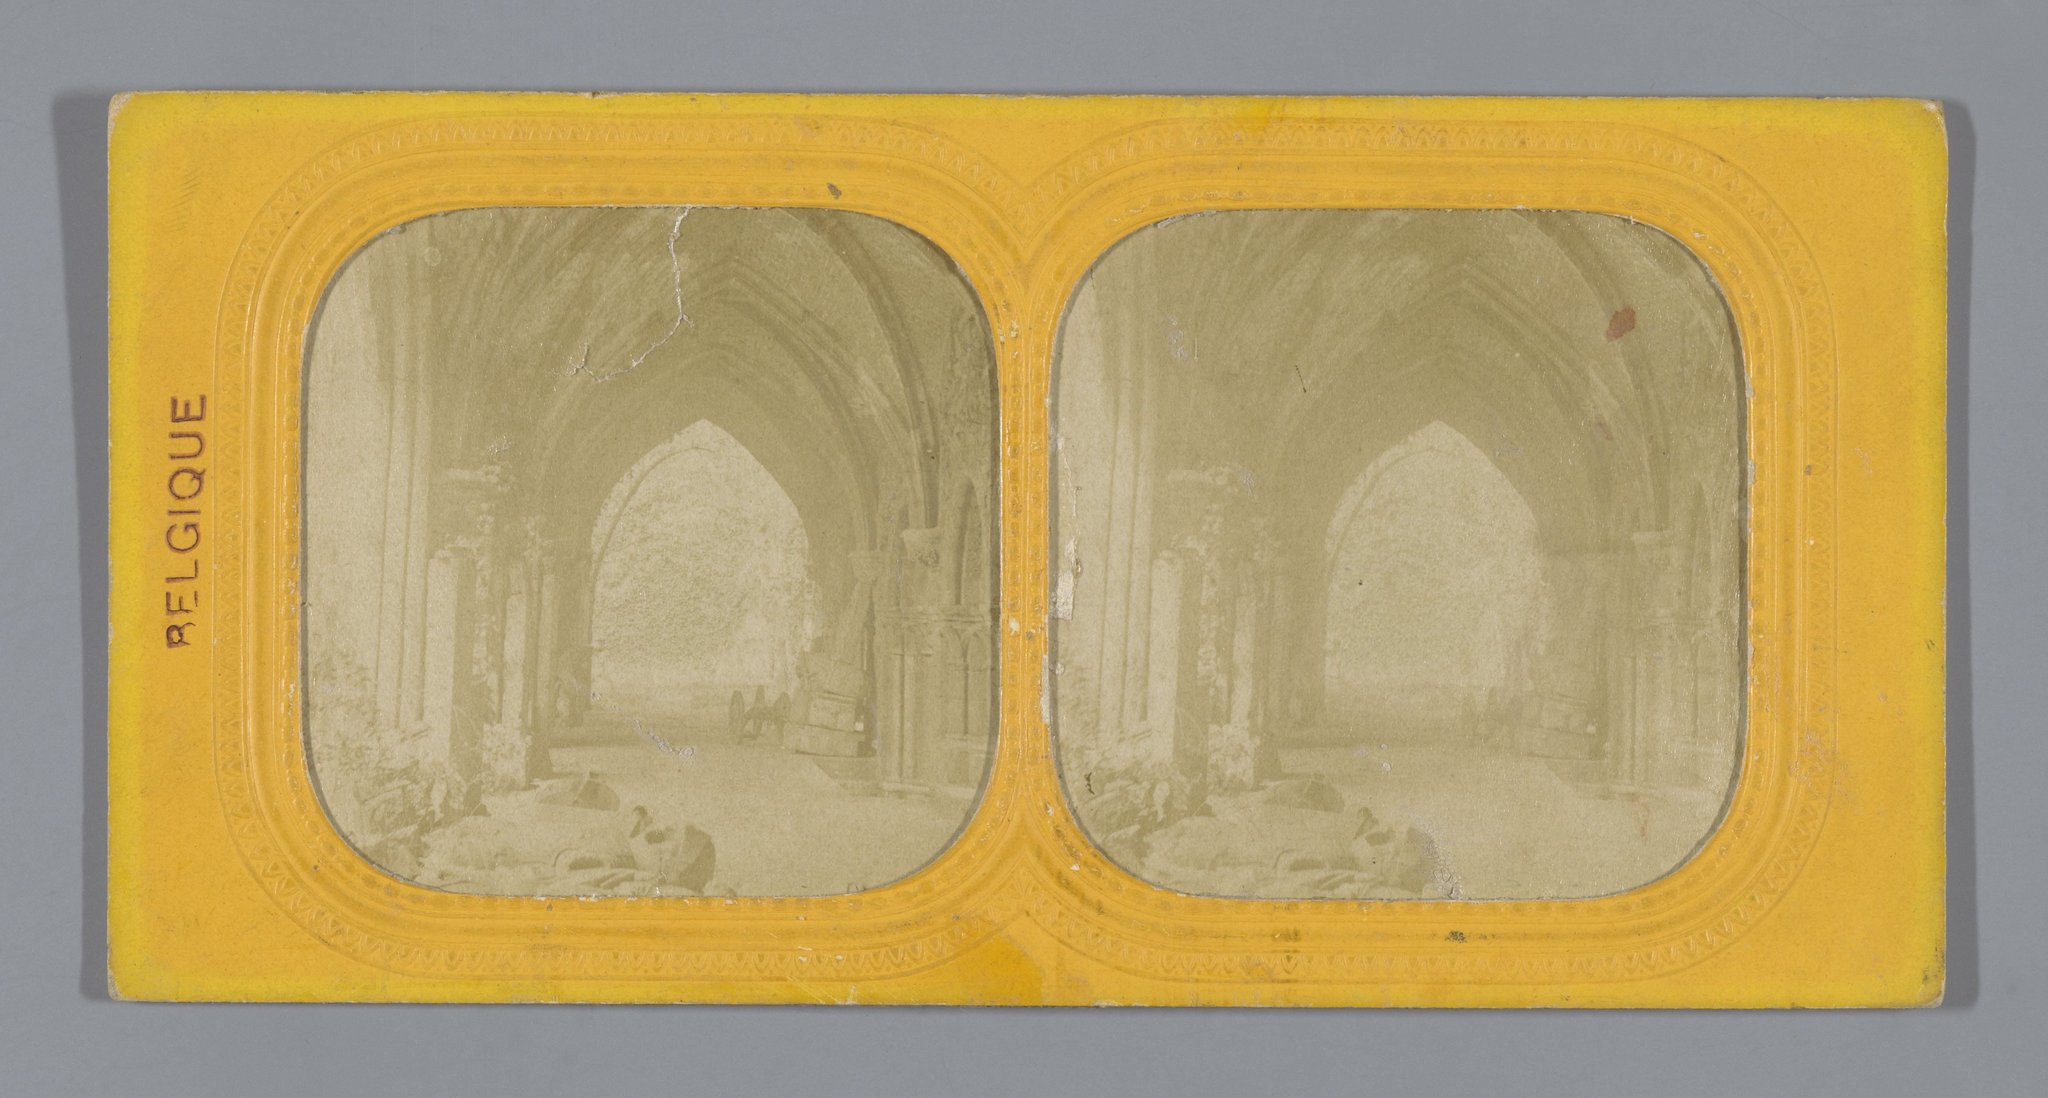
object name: tissue stereograph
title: Ruïnes van de Sint-Baafsabdij in Gent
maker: Anonymous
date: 1865-1875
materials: cardboard, paper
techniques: albumen print, hand coloring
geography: ghent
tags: ruin of church, monastery, etc.